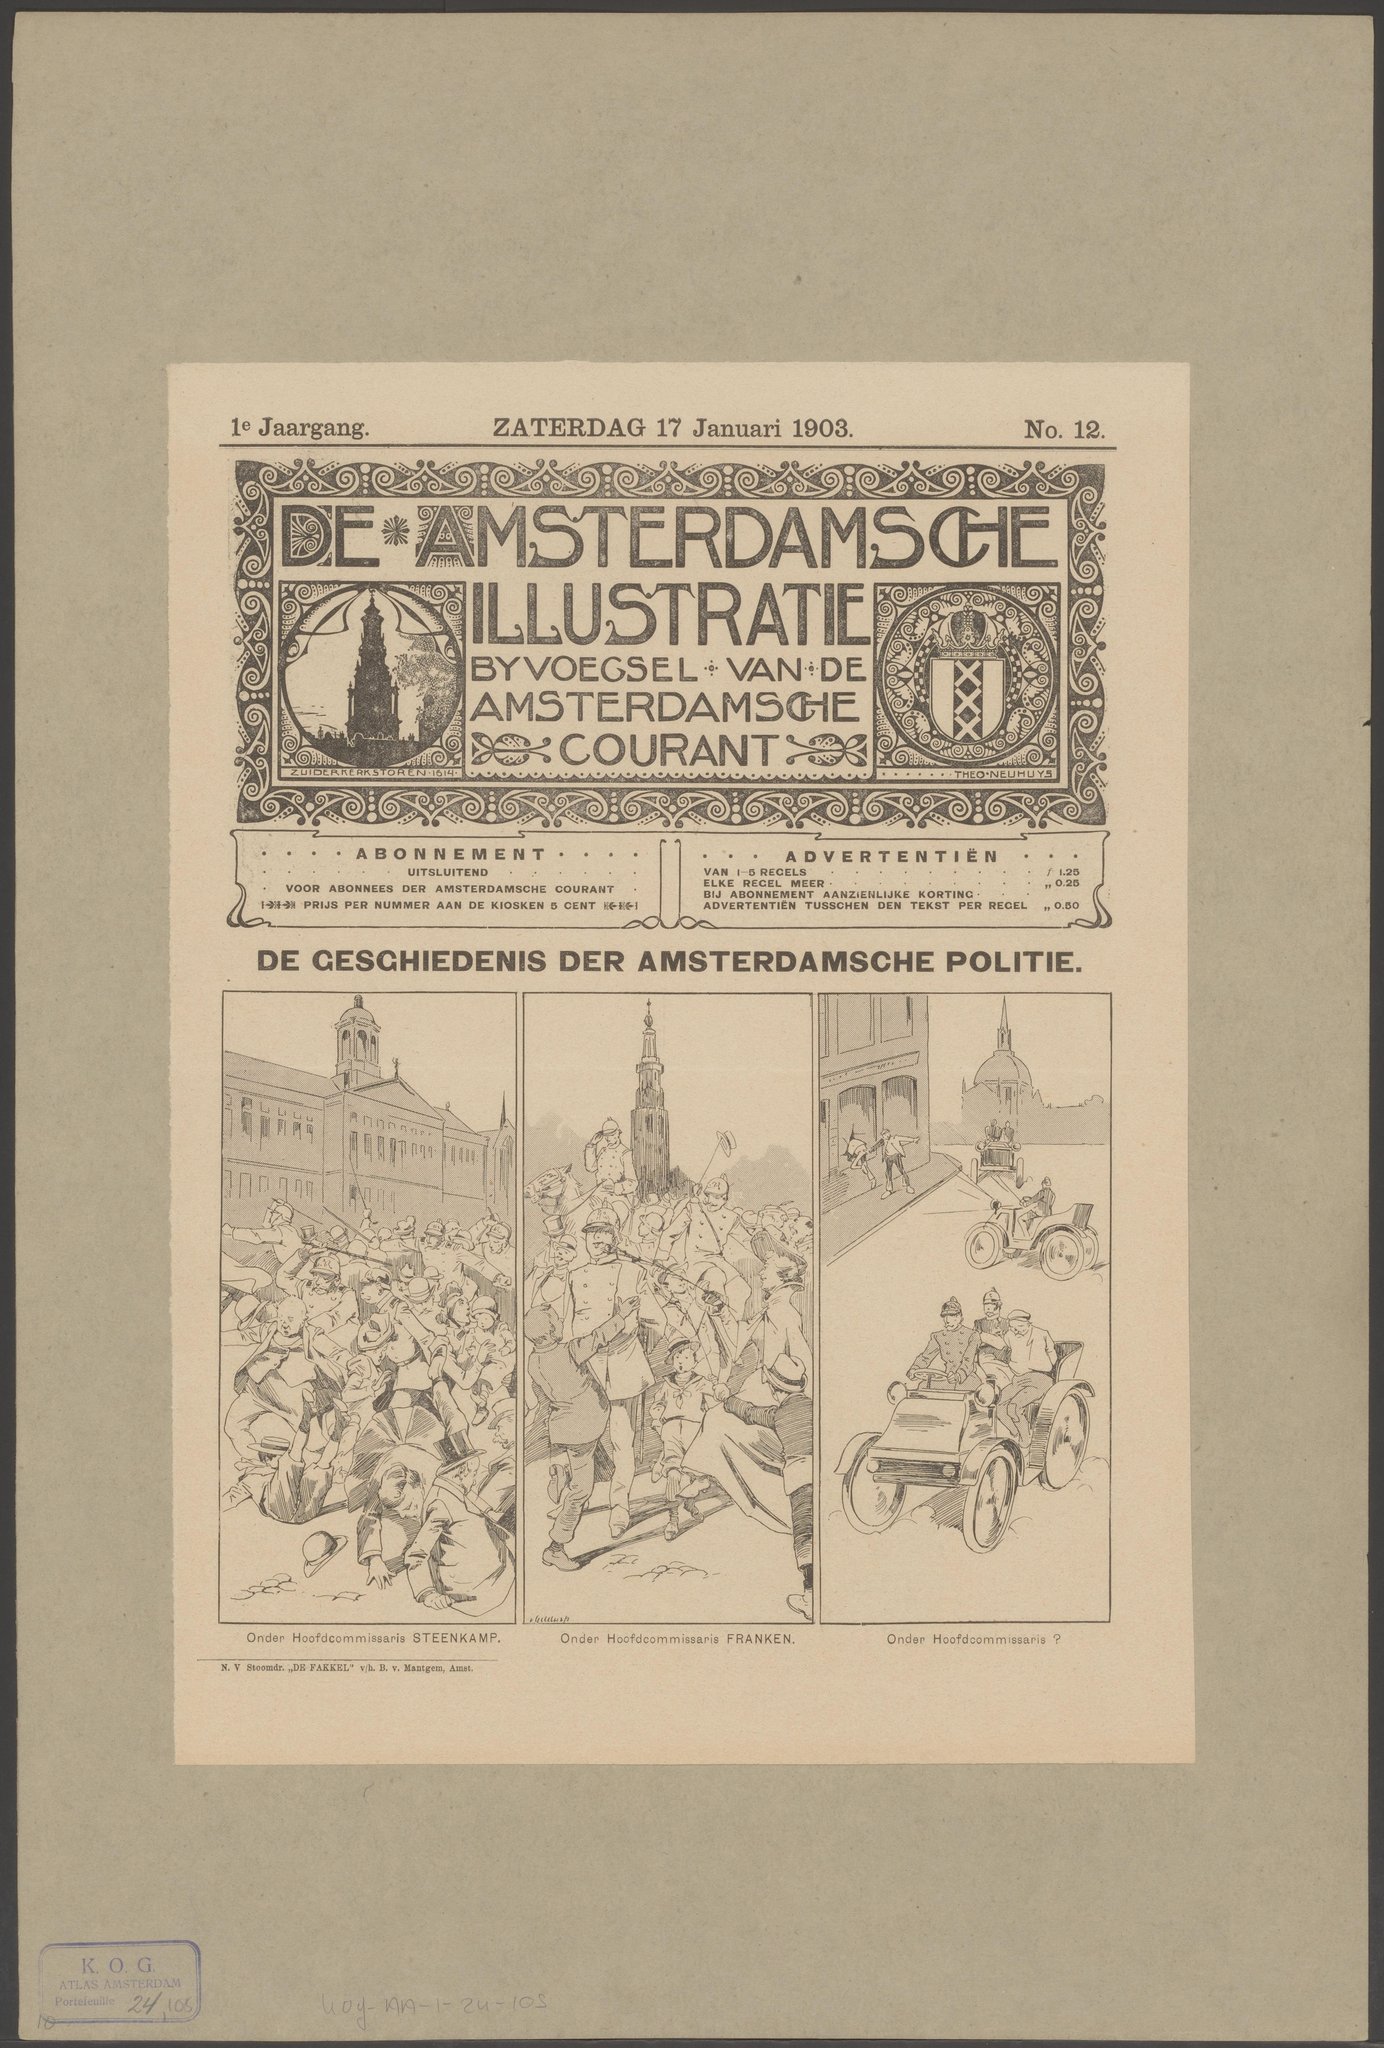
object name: photomechanical print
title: Evolutie van de Amsterdamse politie onder het bestuur van verschillende hoofdcommissarissen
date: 1903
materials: paper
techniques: letterpress printing, line block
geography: netherlands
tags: delft, coat of arms (as symbol of the state, etc.) (+ city; municipal), police, parts of church exterior and annexes: tower, amsterdam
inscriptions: collector's mark: Lugt 1641b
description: Gepubliceerd als bijvoegsel van 'De Amsterdamsche Courant', 17 januari 1903.